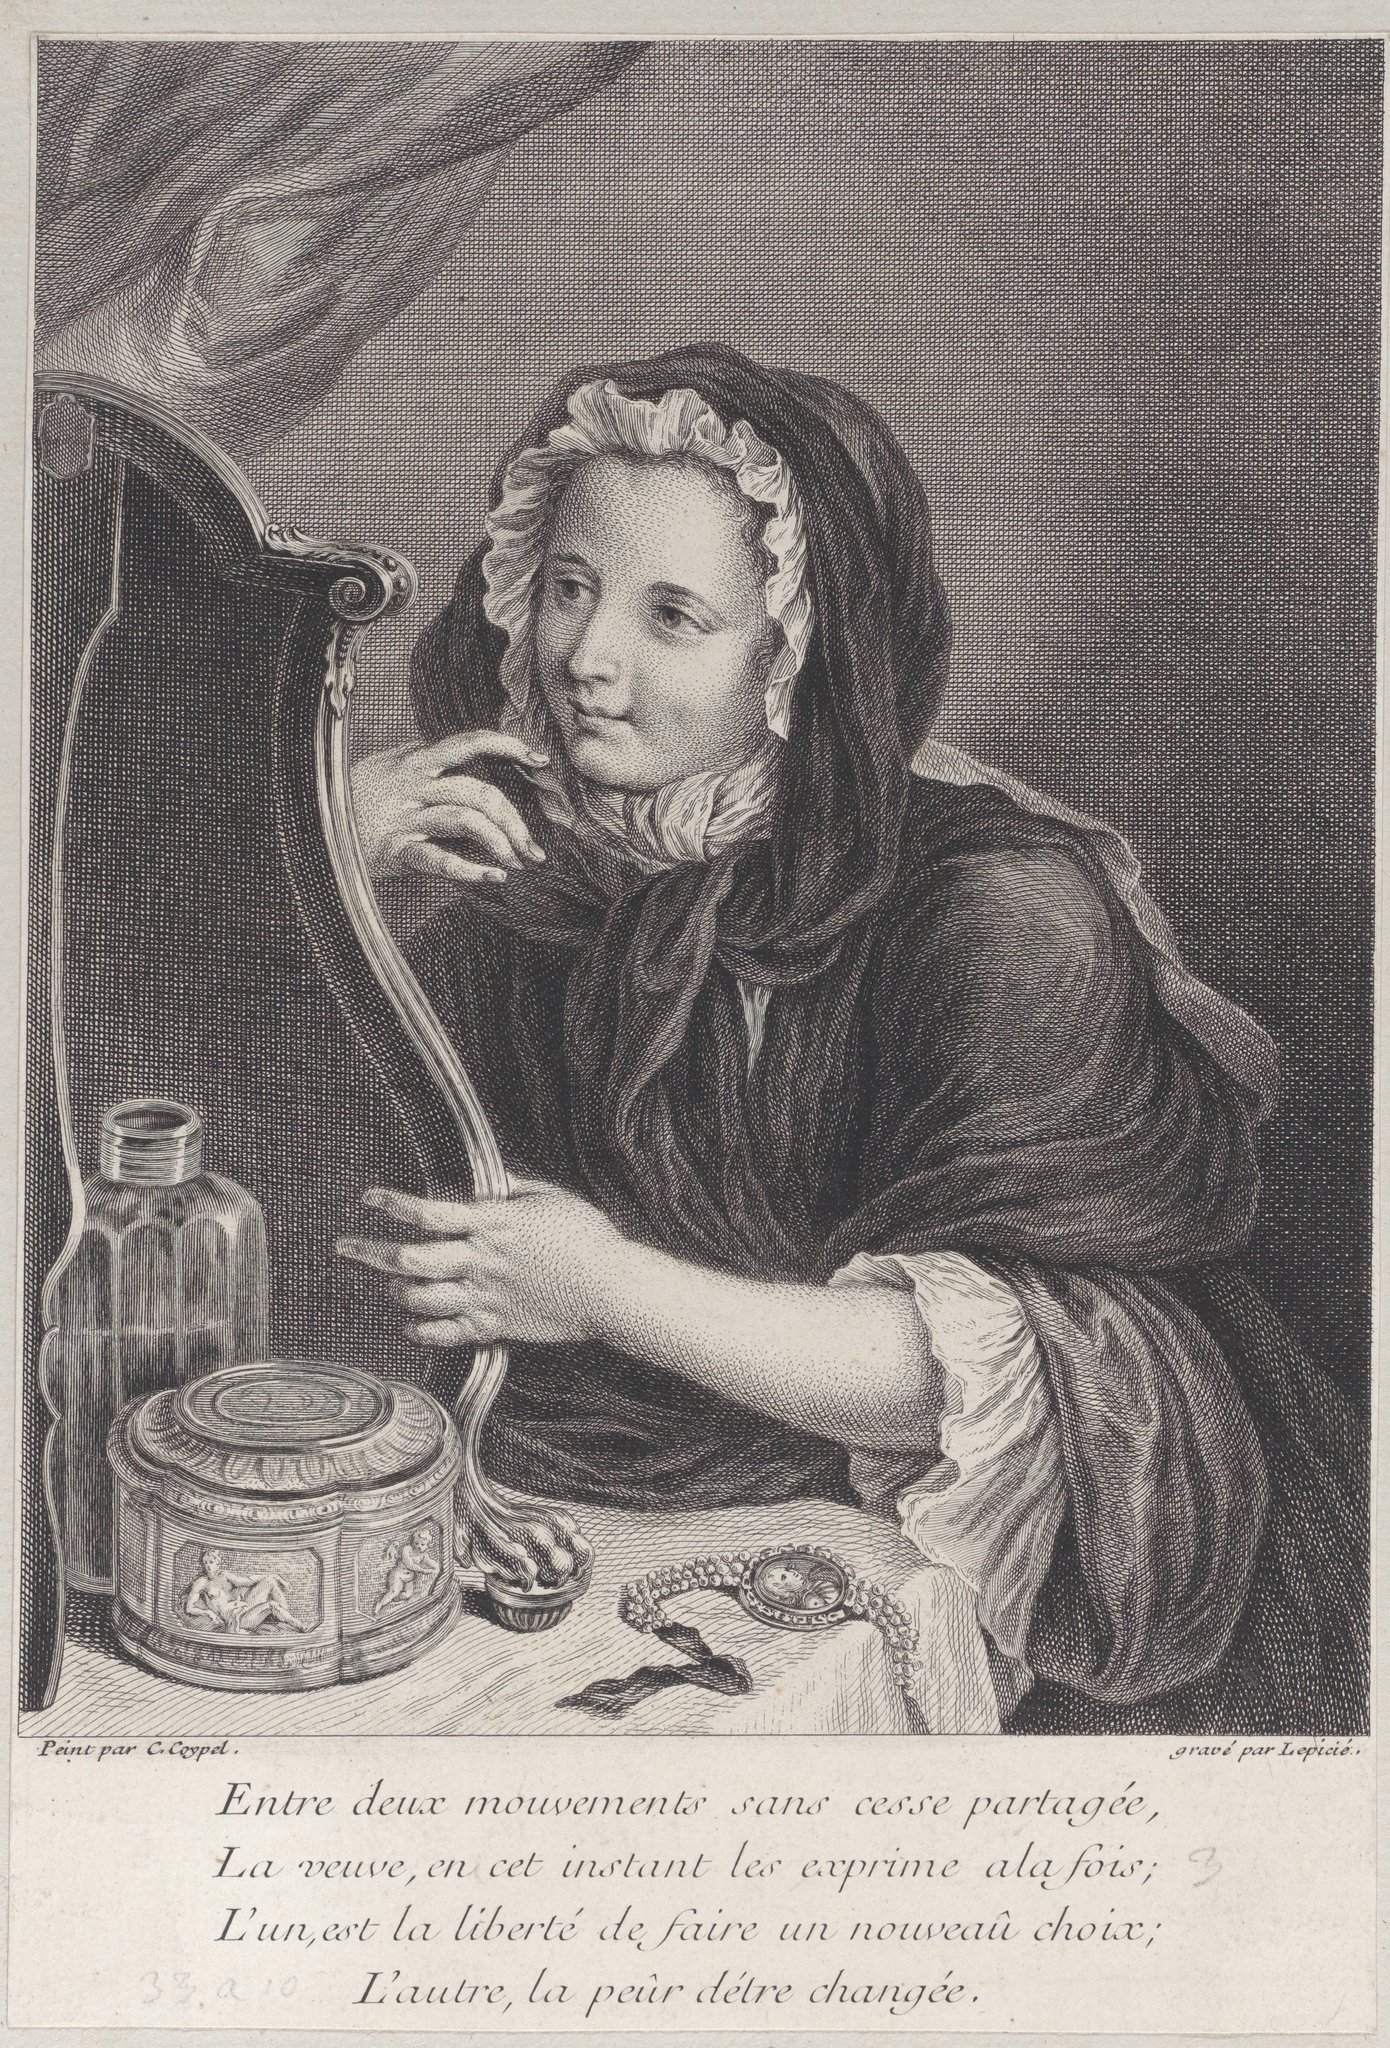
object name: print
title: The Coquettish Widow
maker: bernard lepicié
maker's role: artist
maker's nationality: french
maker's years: 1698-1755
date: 1724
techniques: engraving, etching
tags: women,mirrors